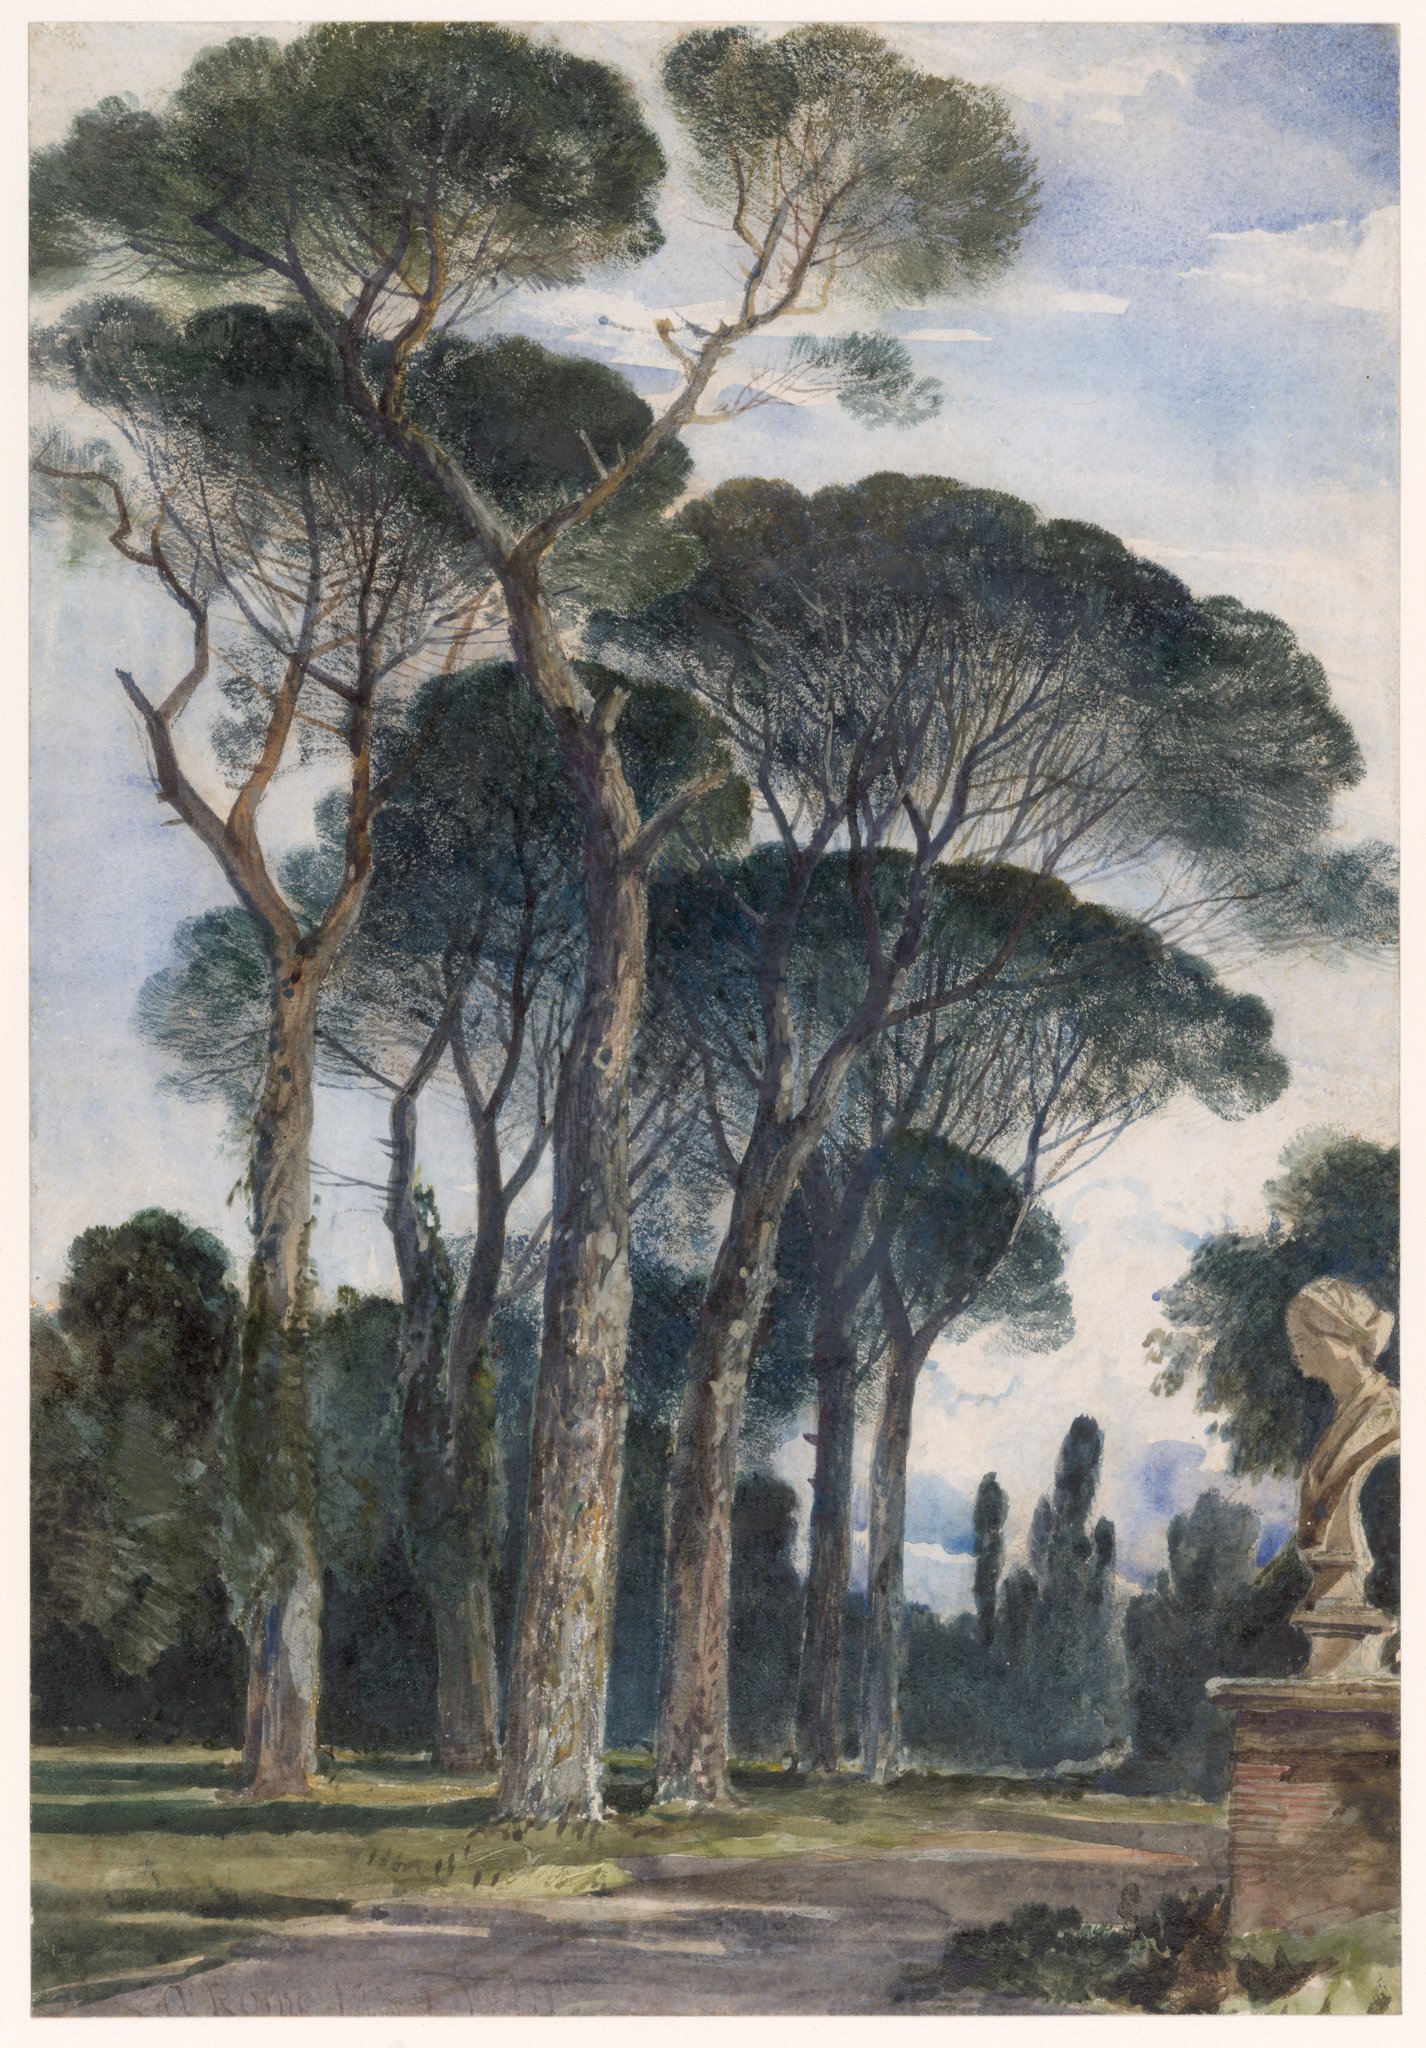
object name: drawing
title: Umbrella pines in the Villa Borghese, Rome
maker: william james müller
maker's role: artist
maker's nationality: british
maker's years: 1812-1845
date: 1839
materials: graphite, gum arabic, watercolor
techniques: drawing, wash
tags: trees